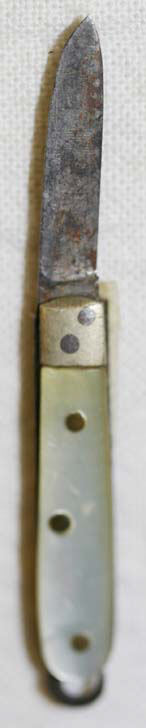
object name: equipment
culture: american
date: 1840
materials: pearl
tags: knives